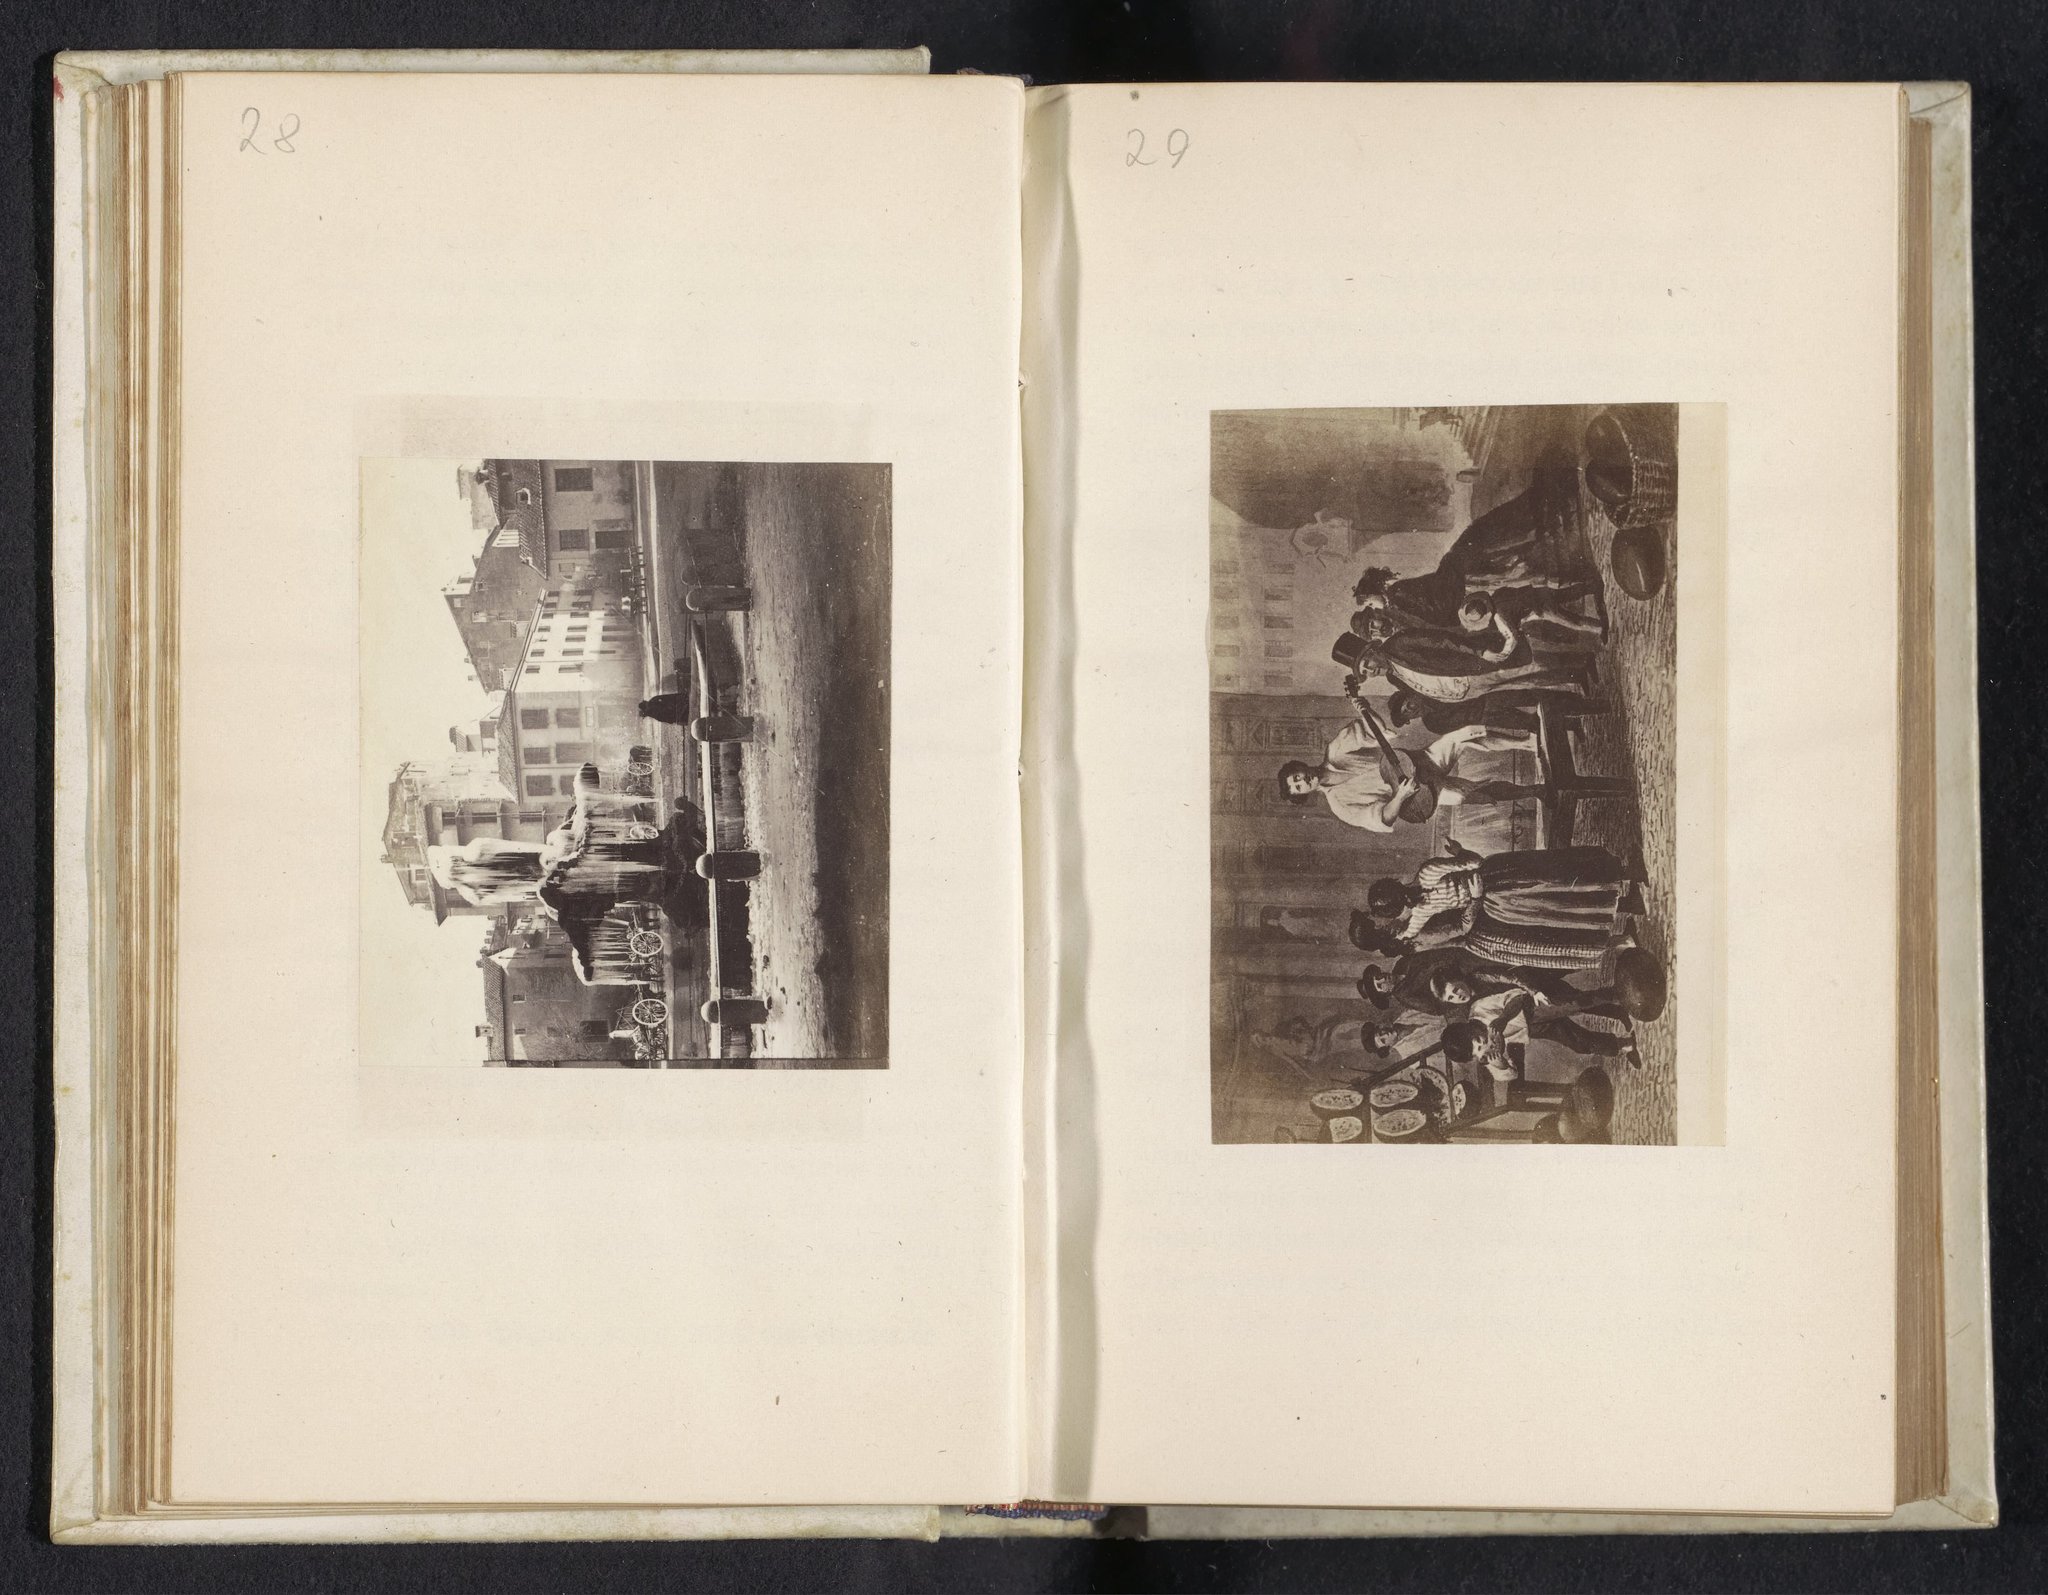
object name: page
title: Bevroren Fontana del Tritone te Rome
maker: Anonymous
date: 1850-1860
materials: photographic support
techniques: albumen print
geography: piazza barberini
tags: frost, freezing weather, ornamental fountain